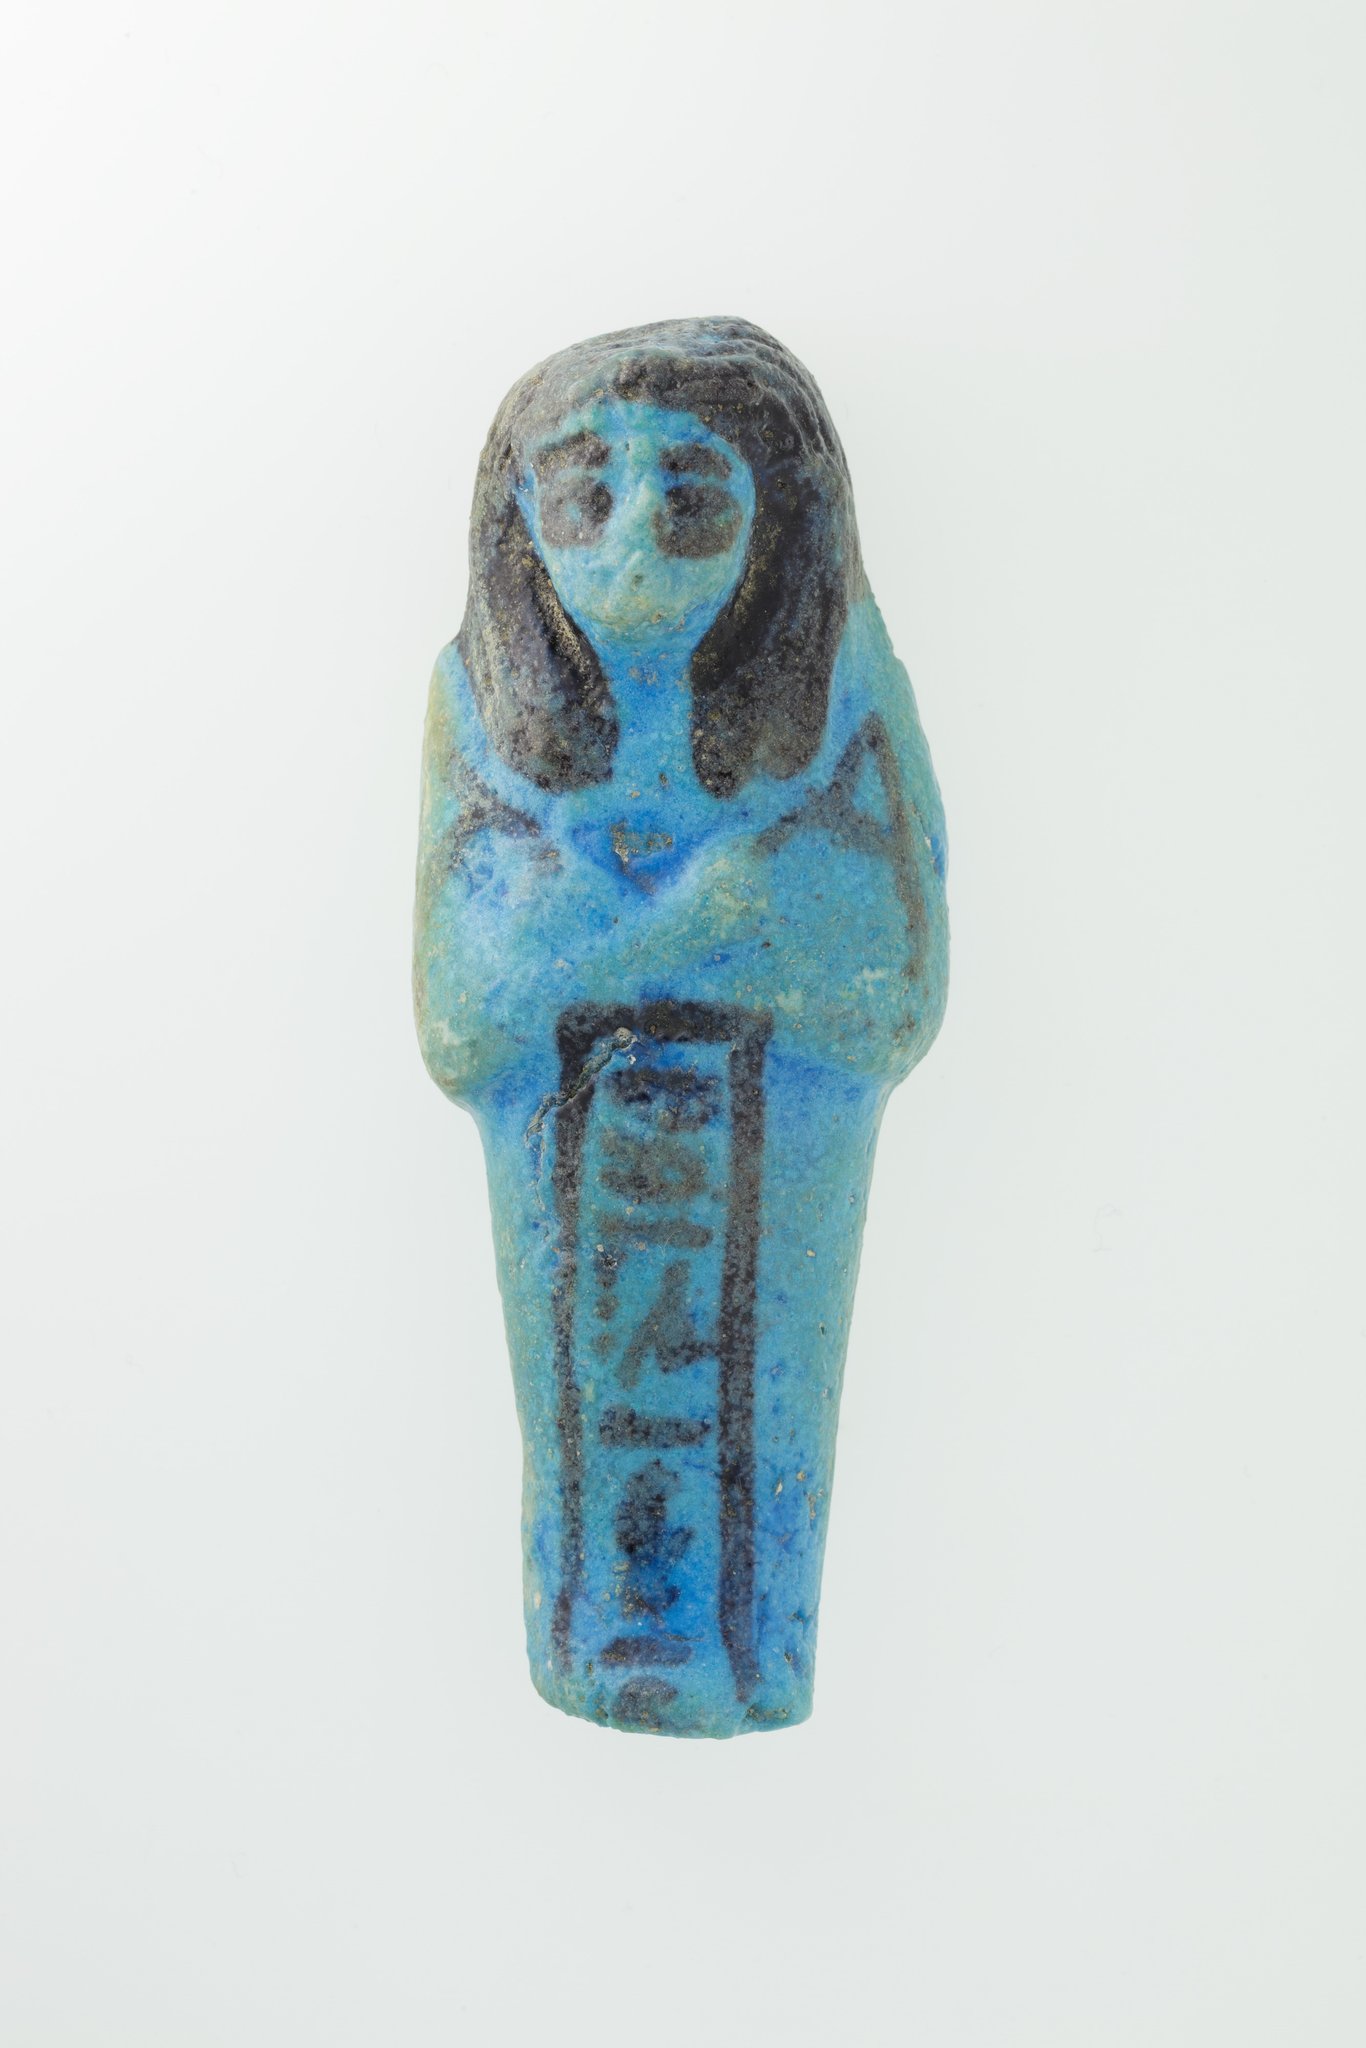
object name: shabti, worker, nauny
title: Worker Shabti of Nauny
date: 1050 BCE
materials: faience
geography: egypt